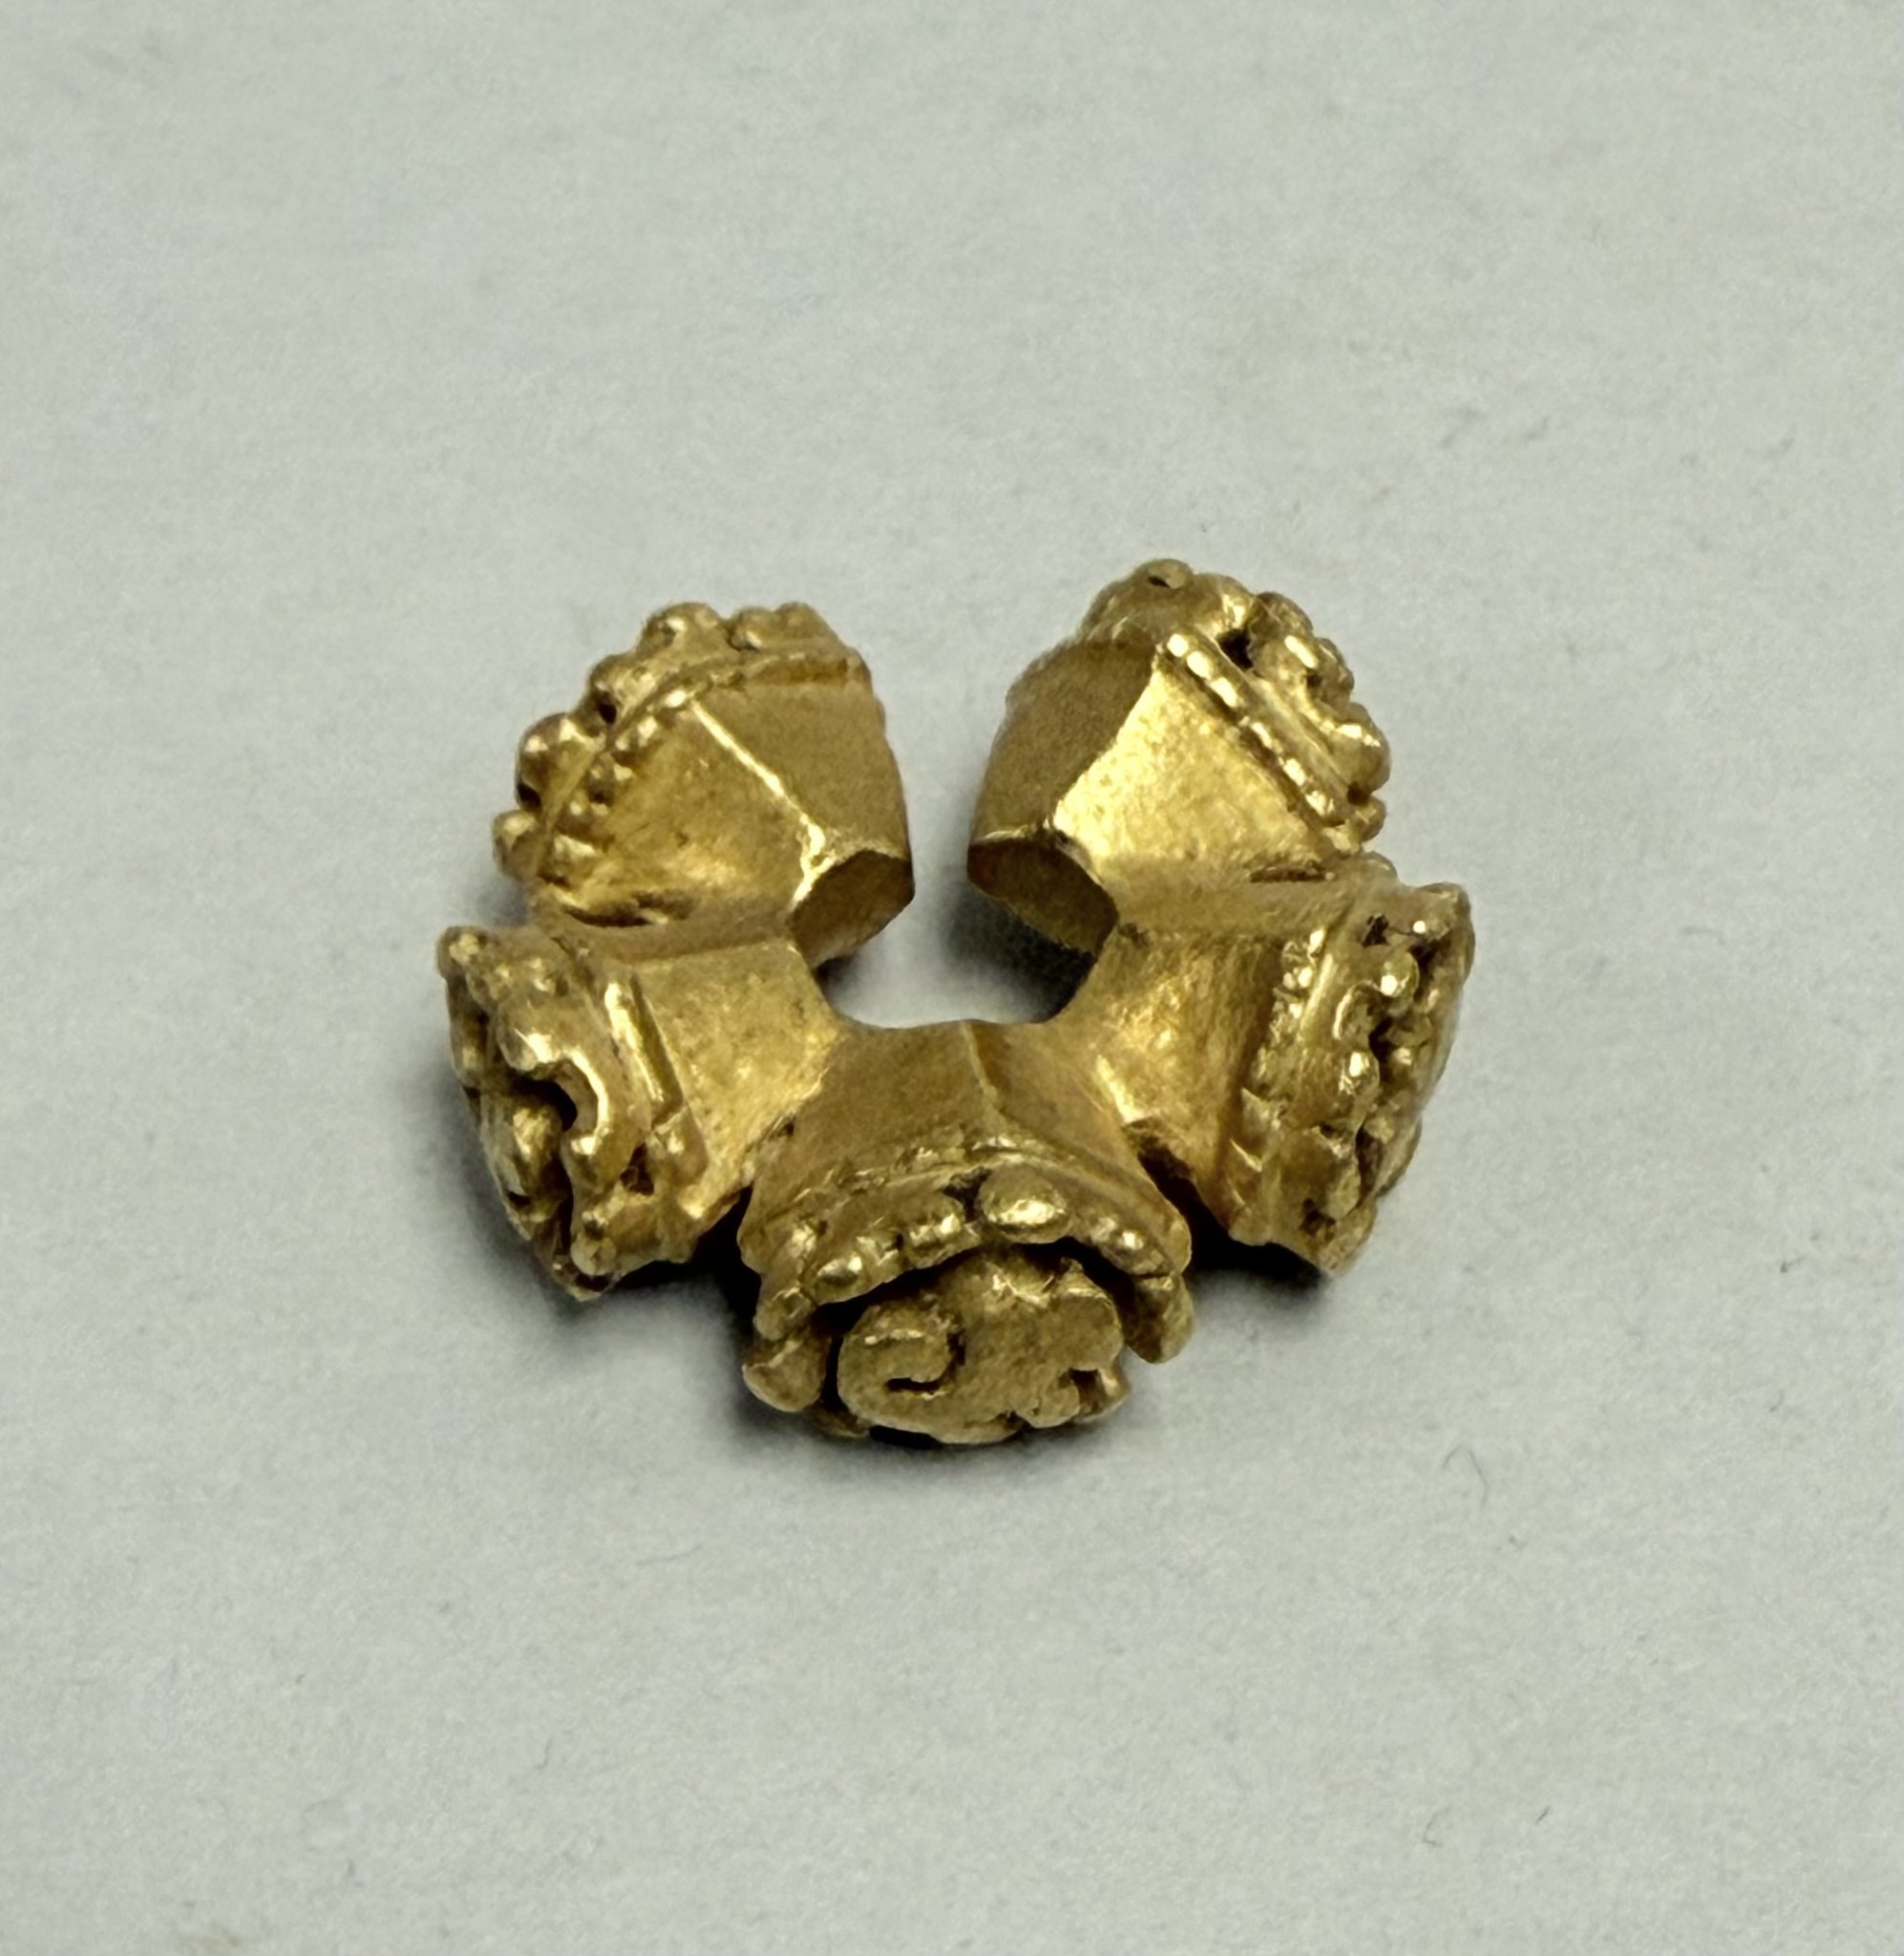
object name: ear ornament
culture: indonesian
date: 701-933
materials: gold